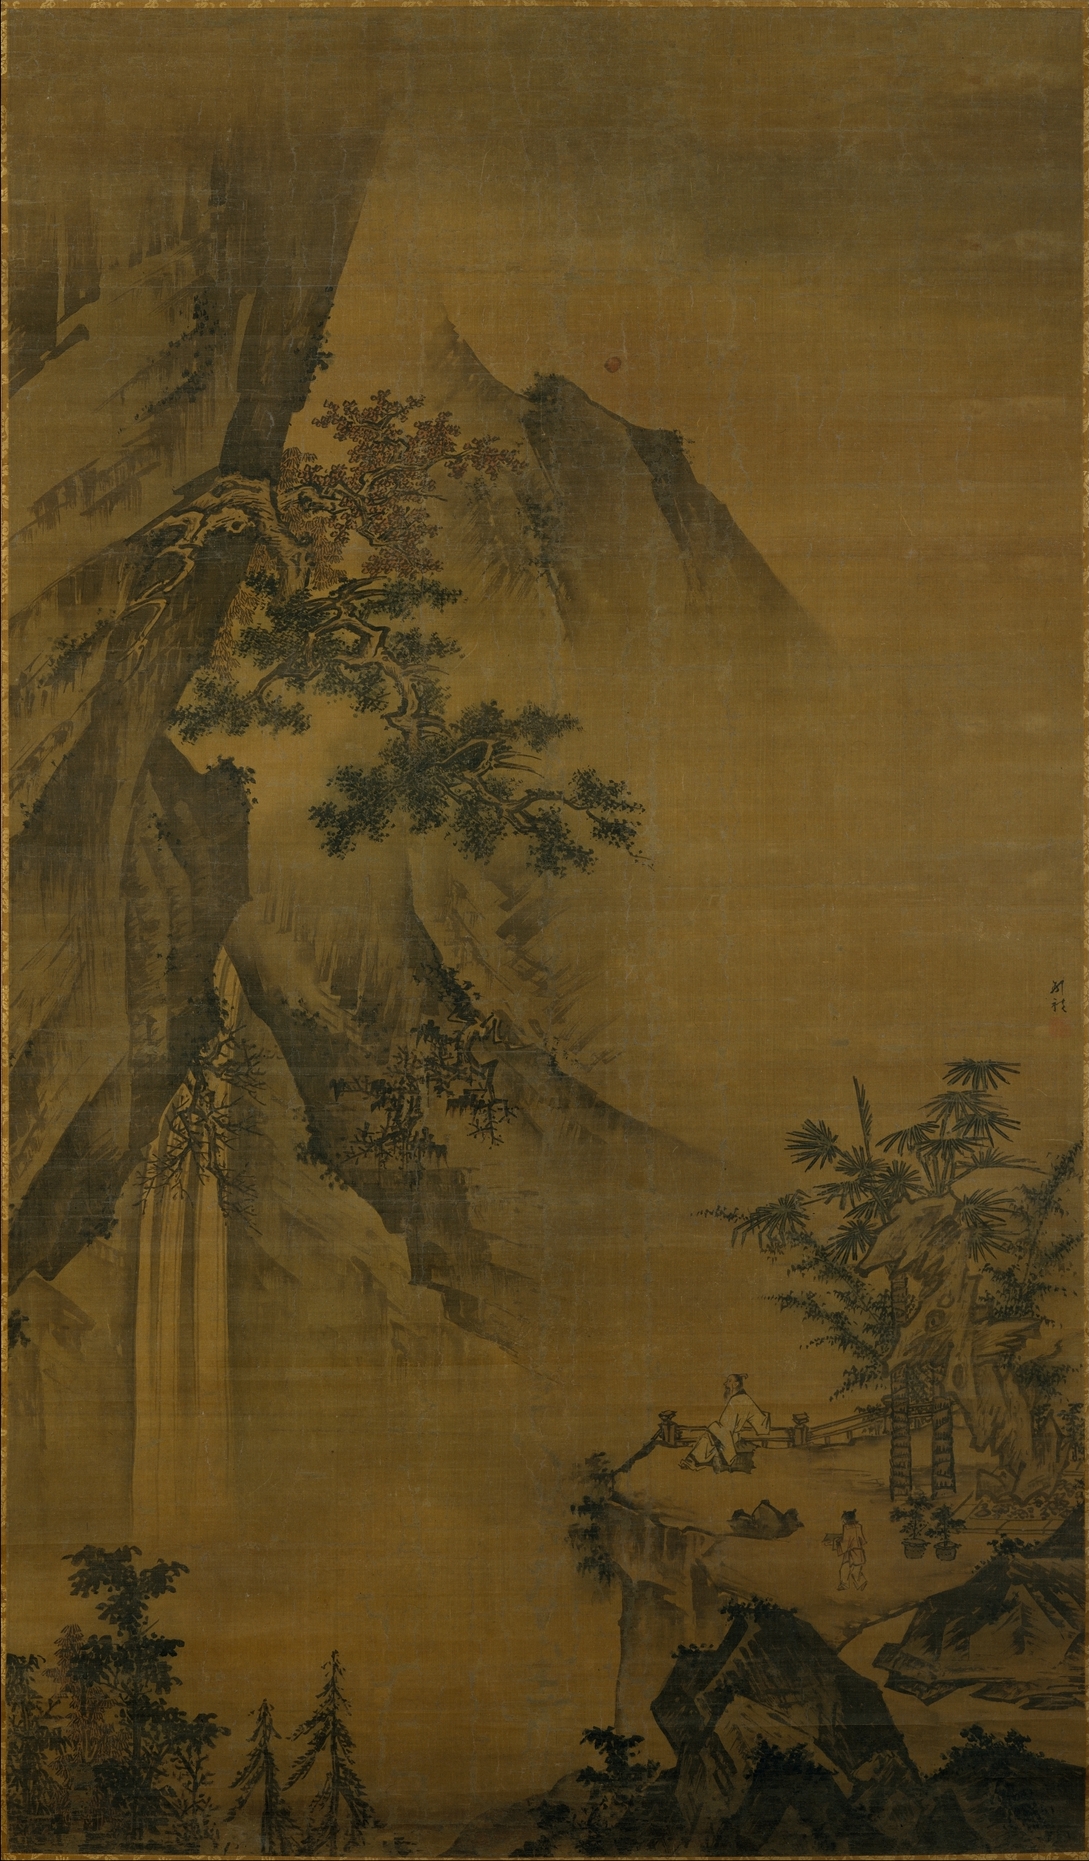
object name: hanging scroll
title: Li Bai gazing at the waterfall on Mount Lu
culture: chinese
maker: zhong li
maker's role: artist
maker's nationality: chinese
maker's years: 1480-1500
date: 1467-1500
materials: ink, silk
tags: men,waterfalls,mountains